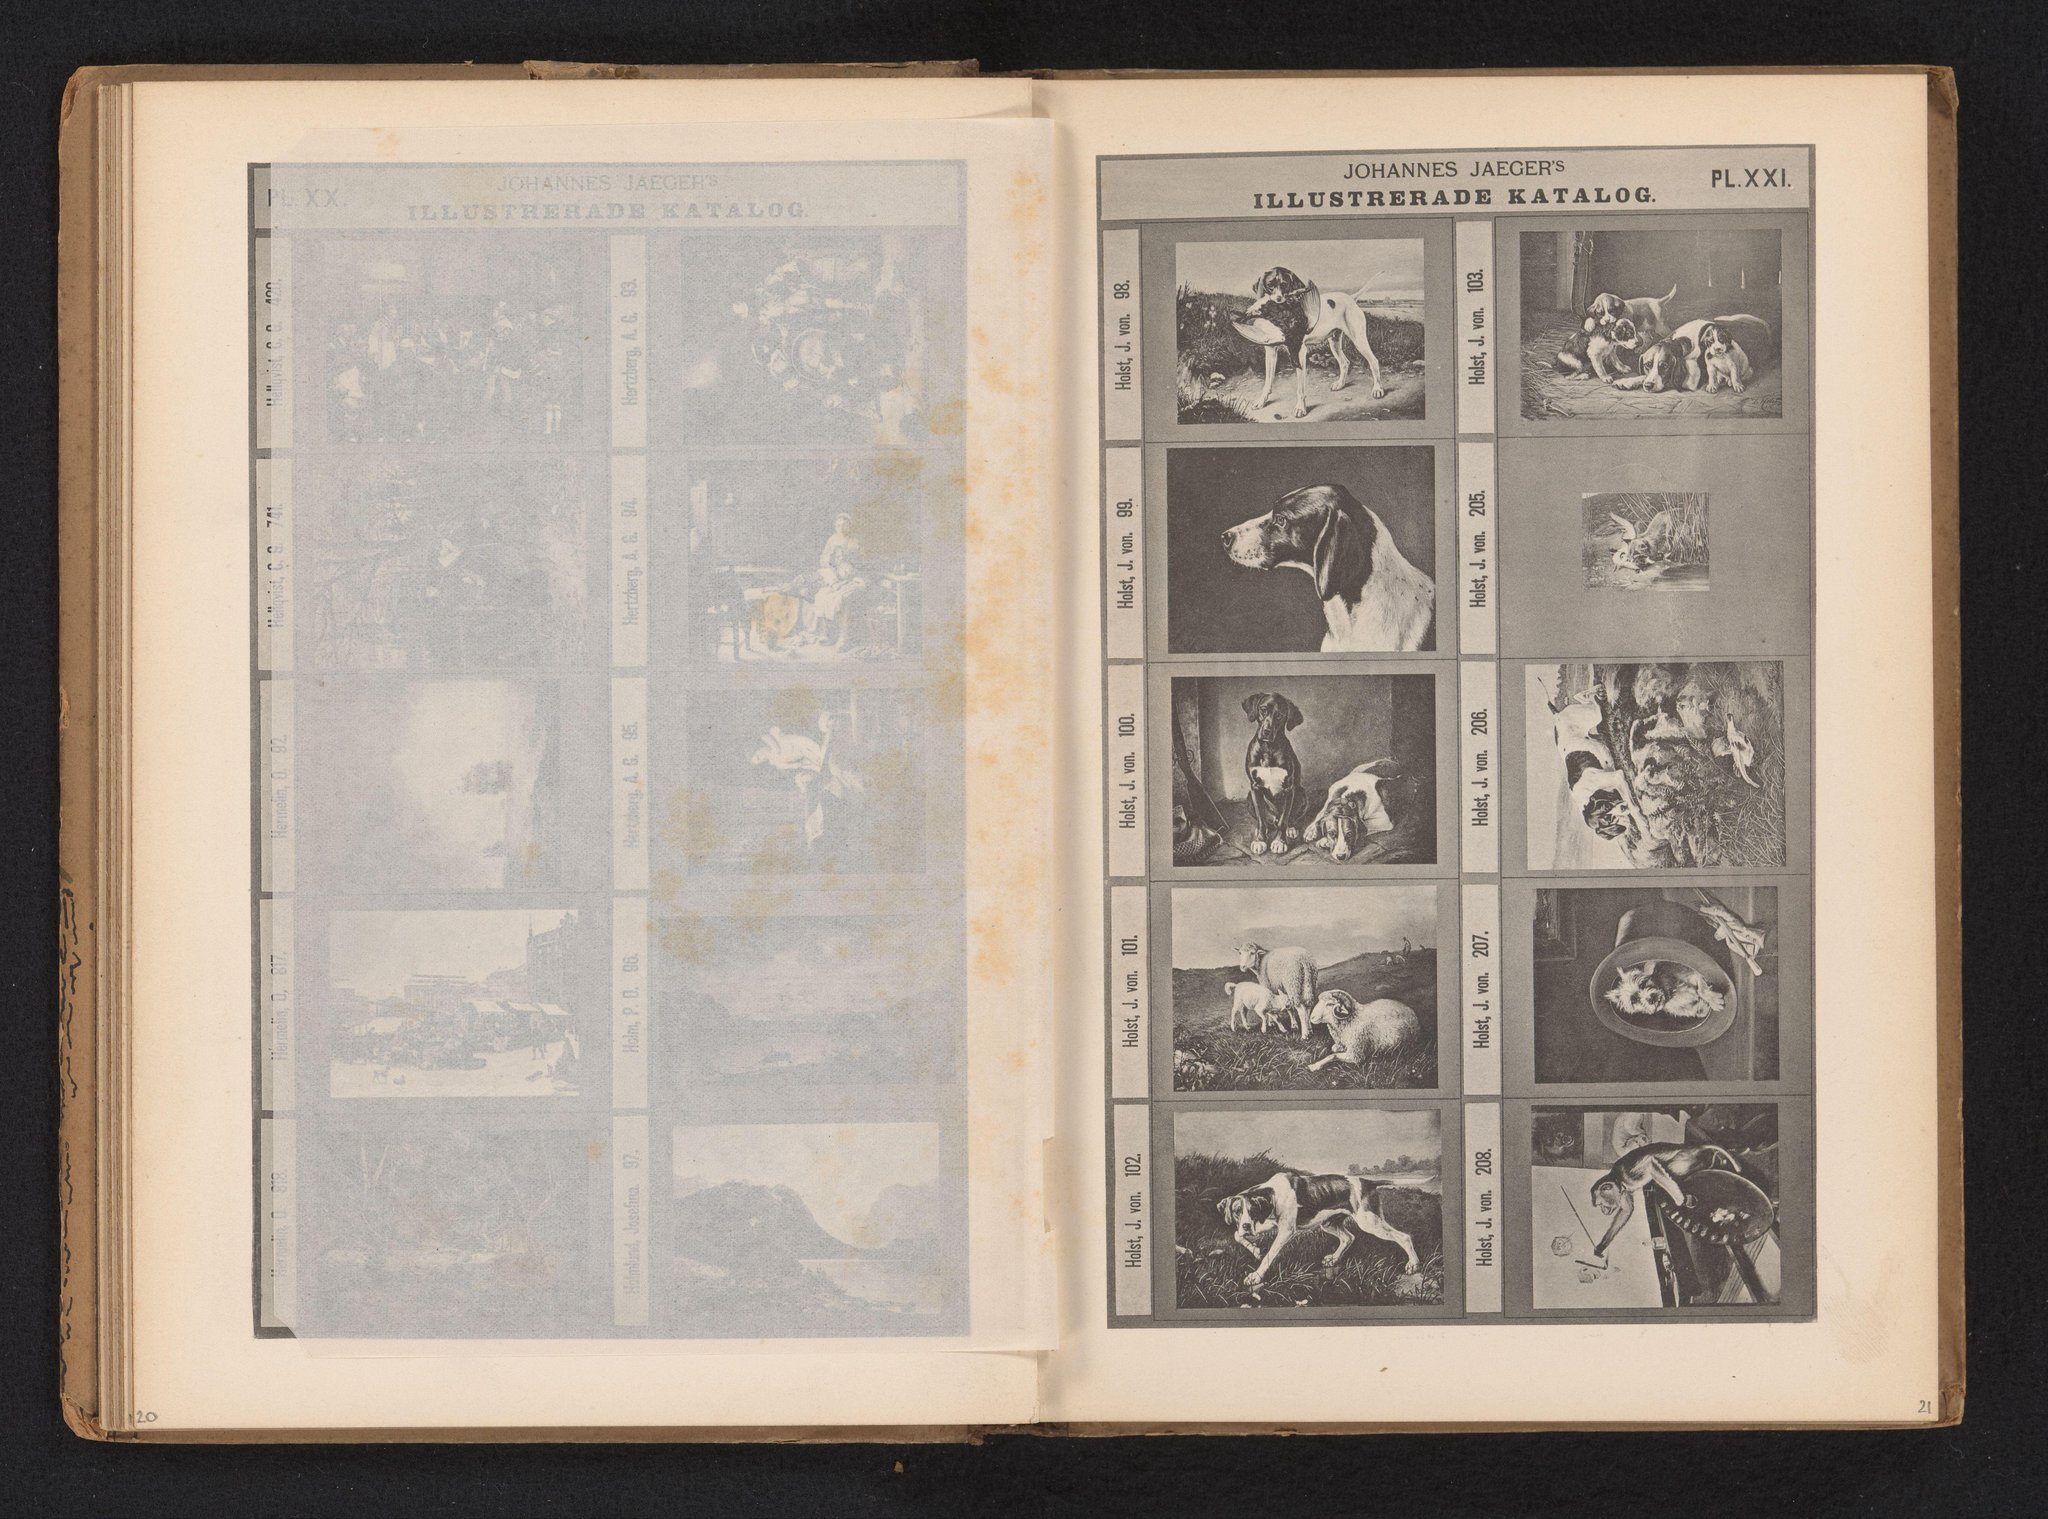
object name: page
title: Johannes Jaeger's Illustrerade Katalog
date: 1872-1882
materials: paper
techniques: photograph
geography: stockholm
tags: monkeys, apes, sheep, picture, painting, dog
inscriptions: number: ‘PL. XXI.’